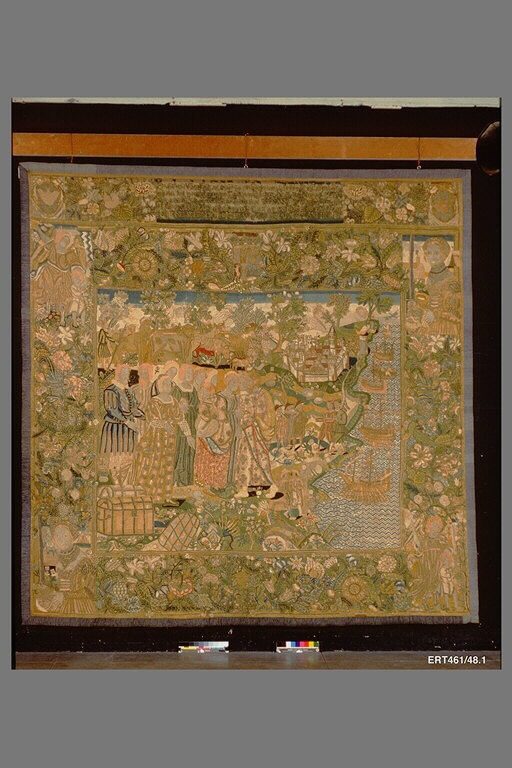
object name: hanging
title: Galcerán de Pinós Preventing the Shipment of the Ransom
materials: canvas, metal thread, silk, wool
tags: men,women,angels,boats